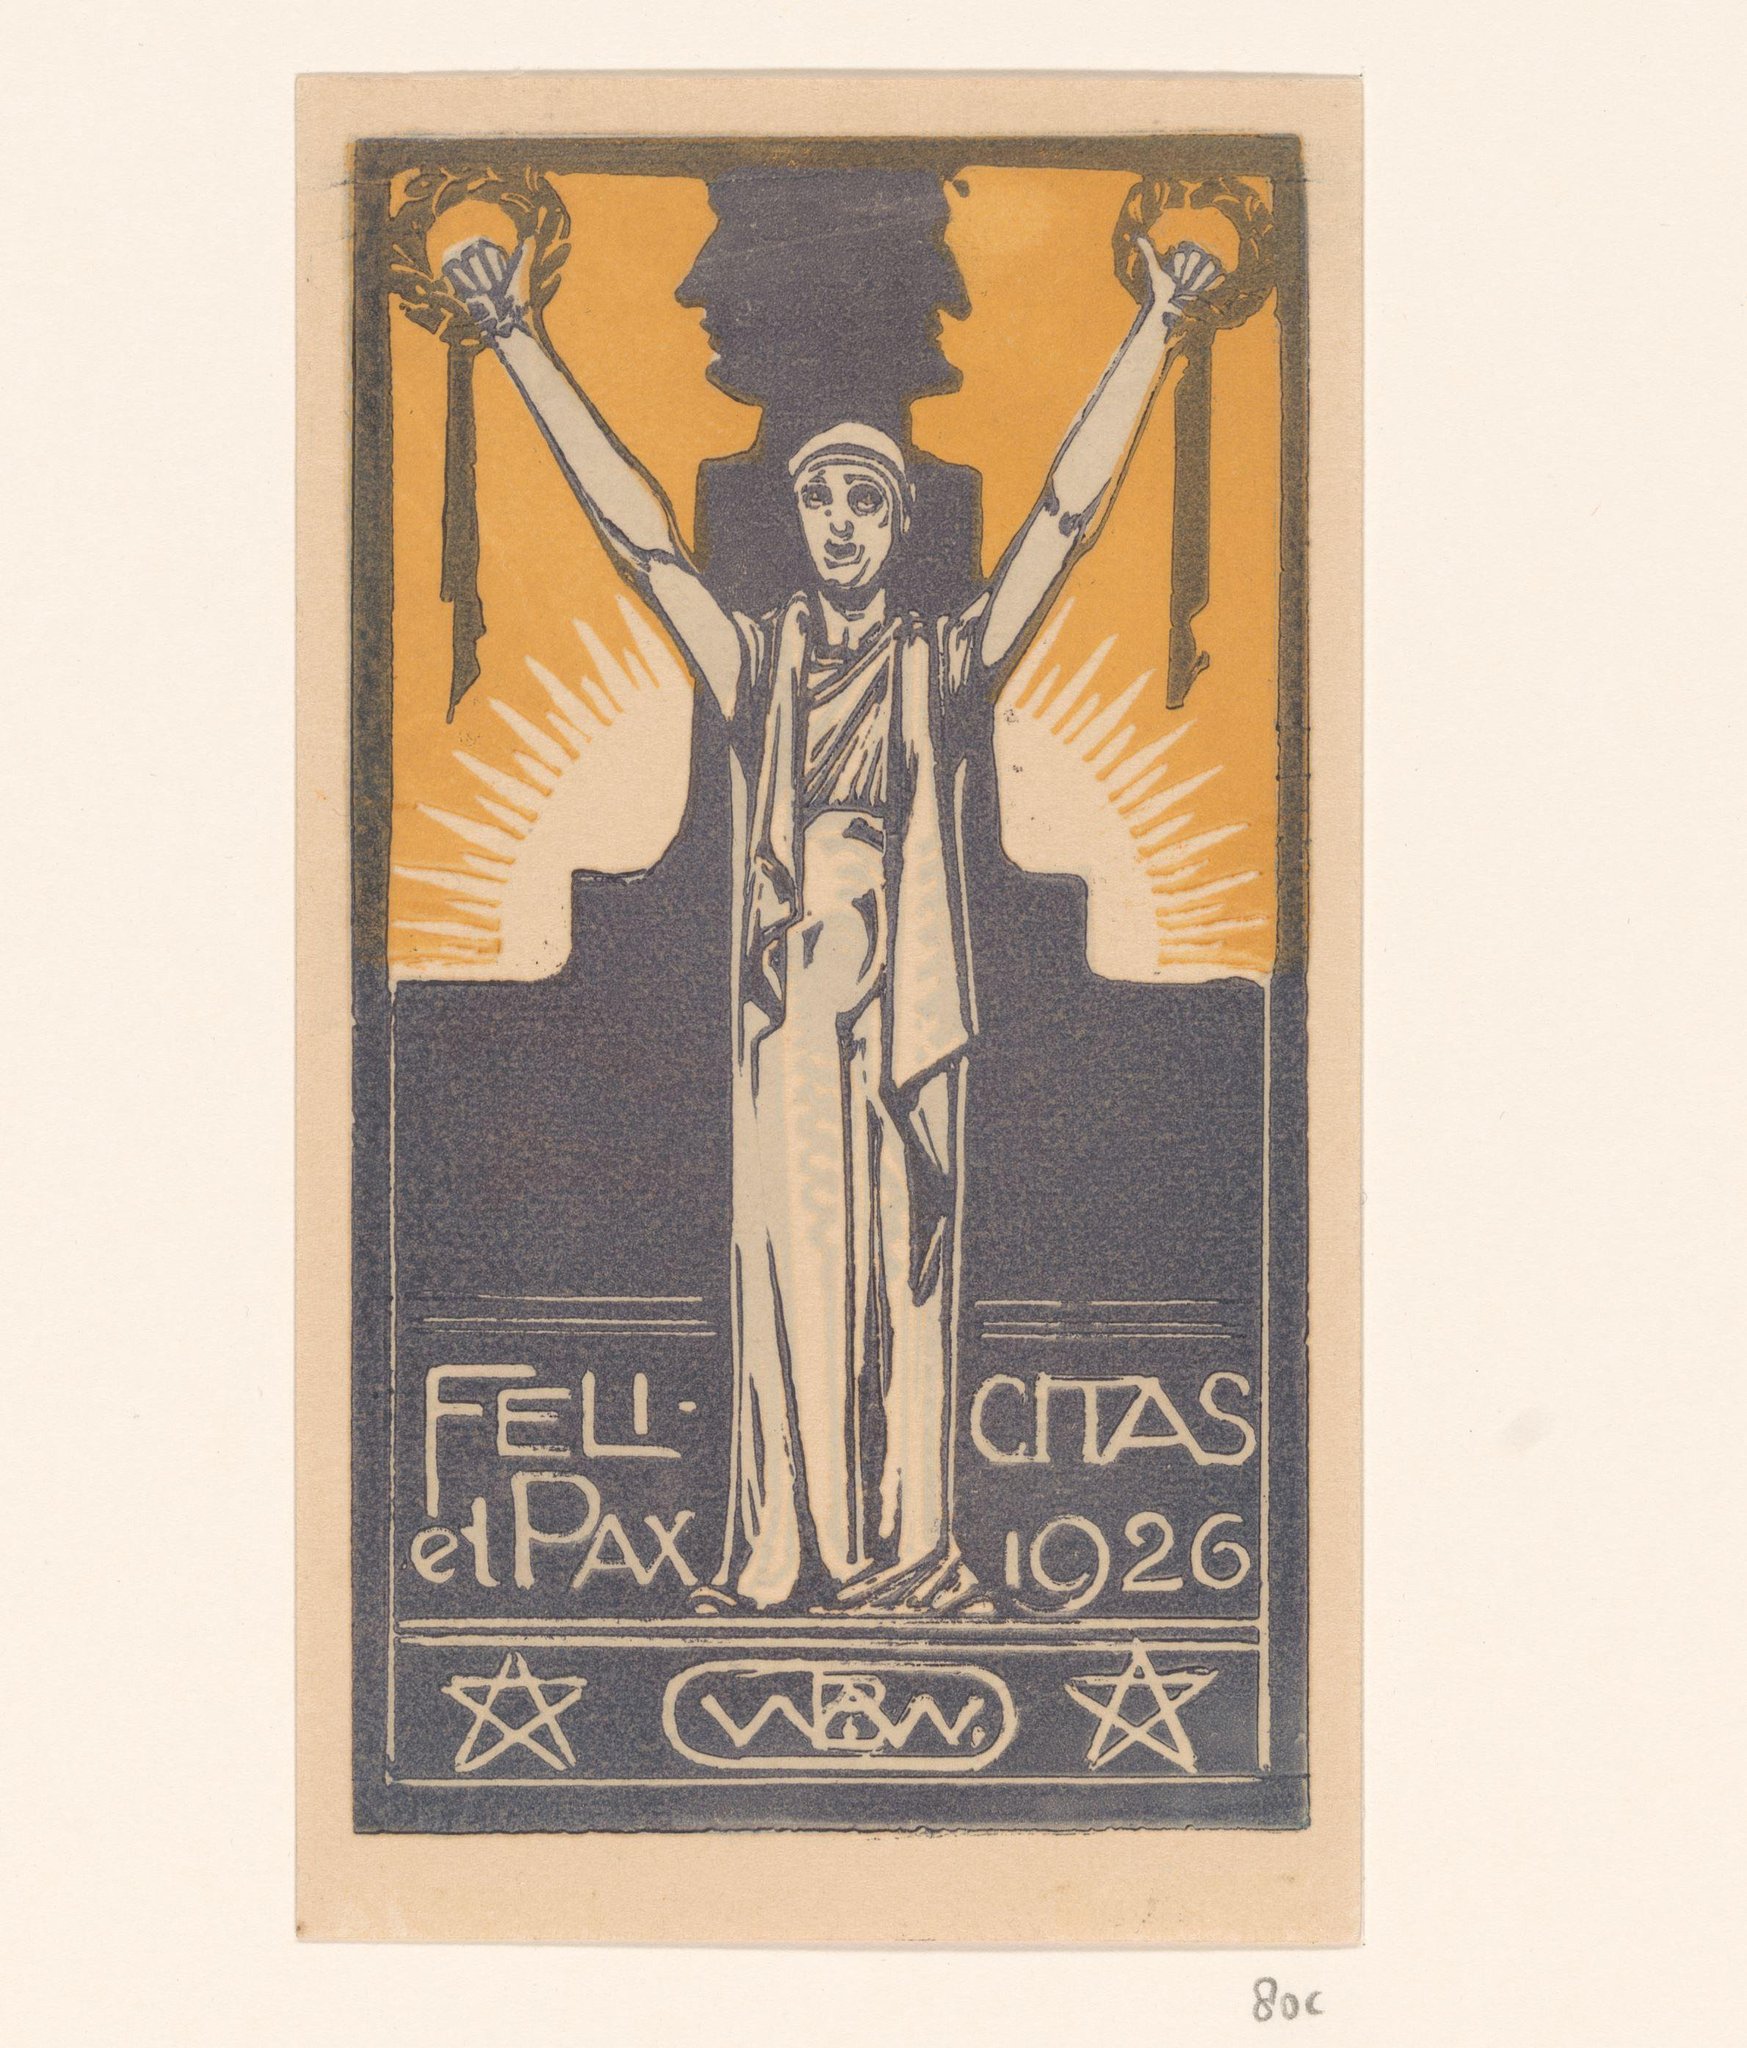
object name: print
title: Felicitas et Pax 1926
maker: bernard willem wierink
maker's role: draughtsman, print maker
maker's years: 1856-1939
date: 1926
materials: paper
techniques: relief print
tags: symbols, allegories of peace, 'pax'; 'pace' (ripa)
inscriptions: collector's mark: Lugt 2228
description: Deze prent is vermoedelijk een plaatsnede, ook al wordt in de literatuur veelal gesproken over een houtsnede. Voor zover Wierink zijn prenten in hoogdruk zelf nader heeft omschreven, heeft hij altijd de term 'plaatsnede' gebruikt.